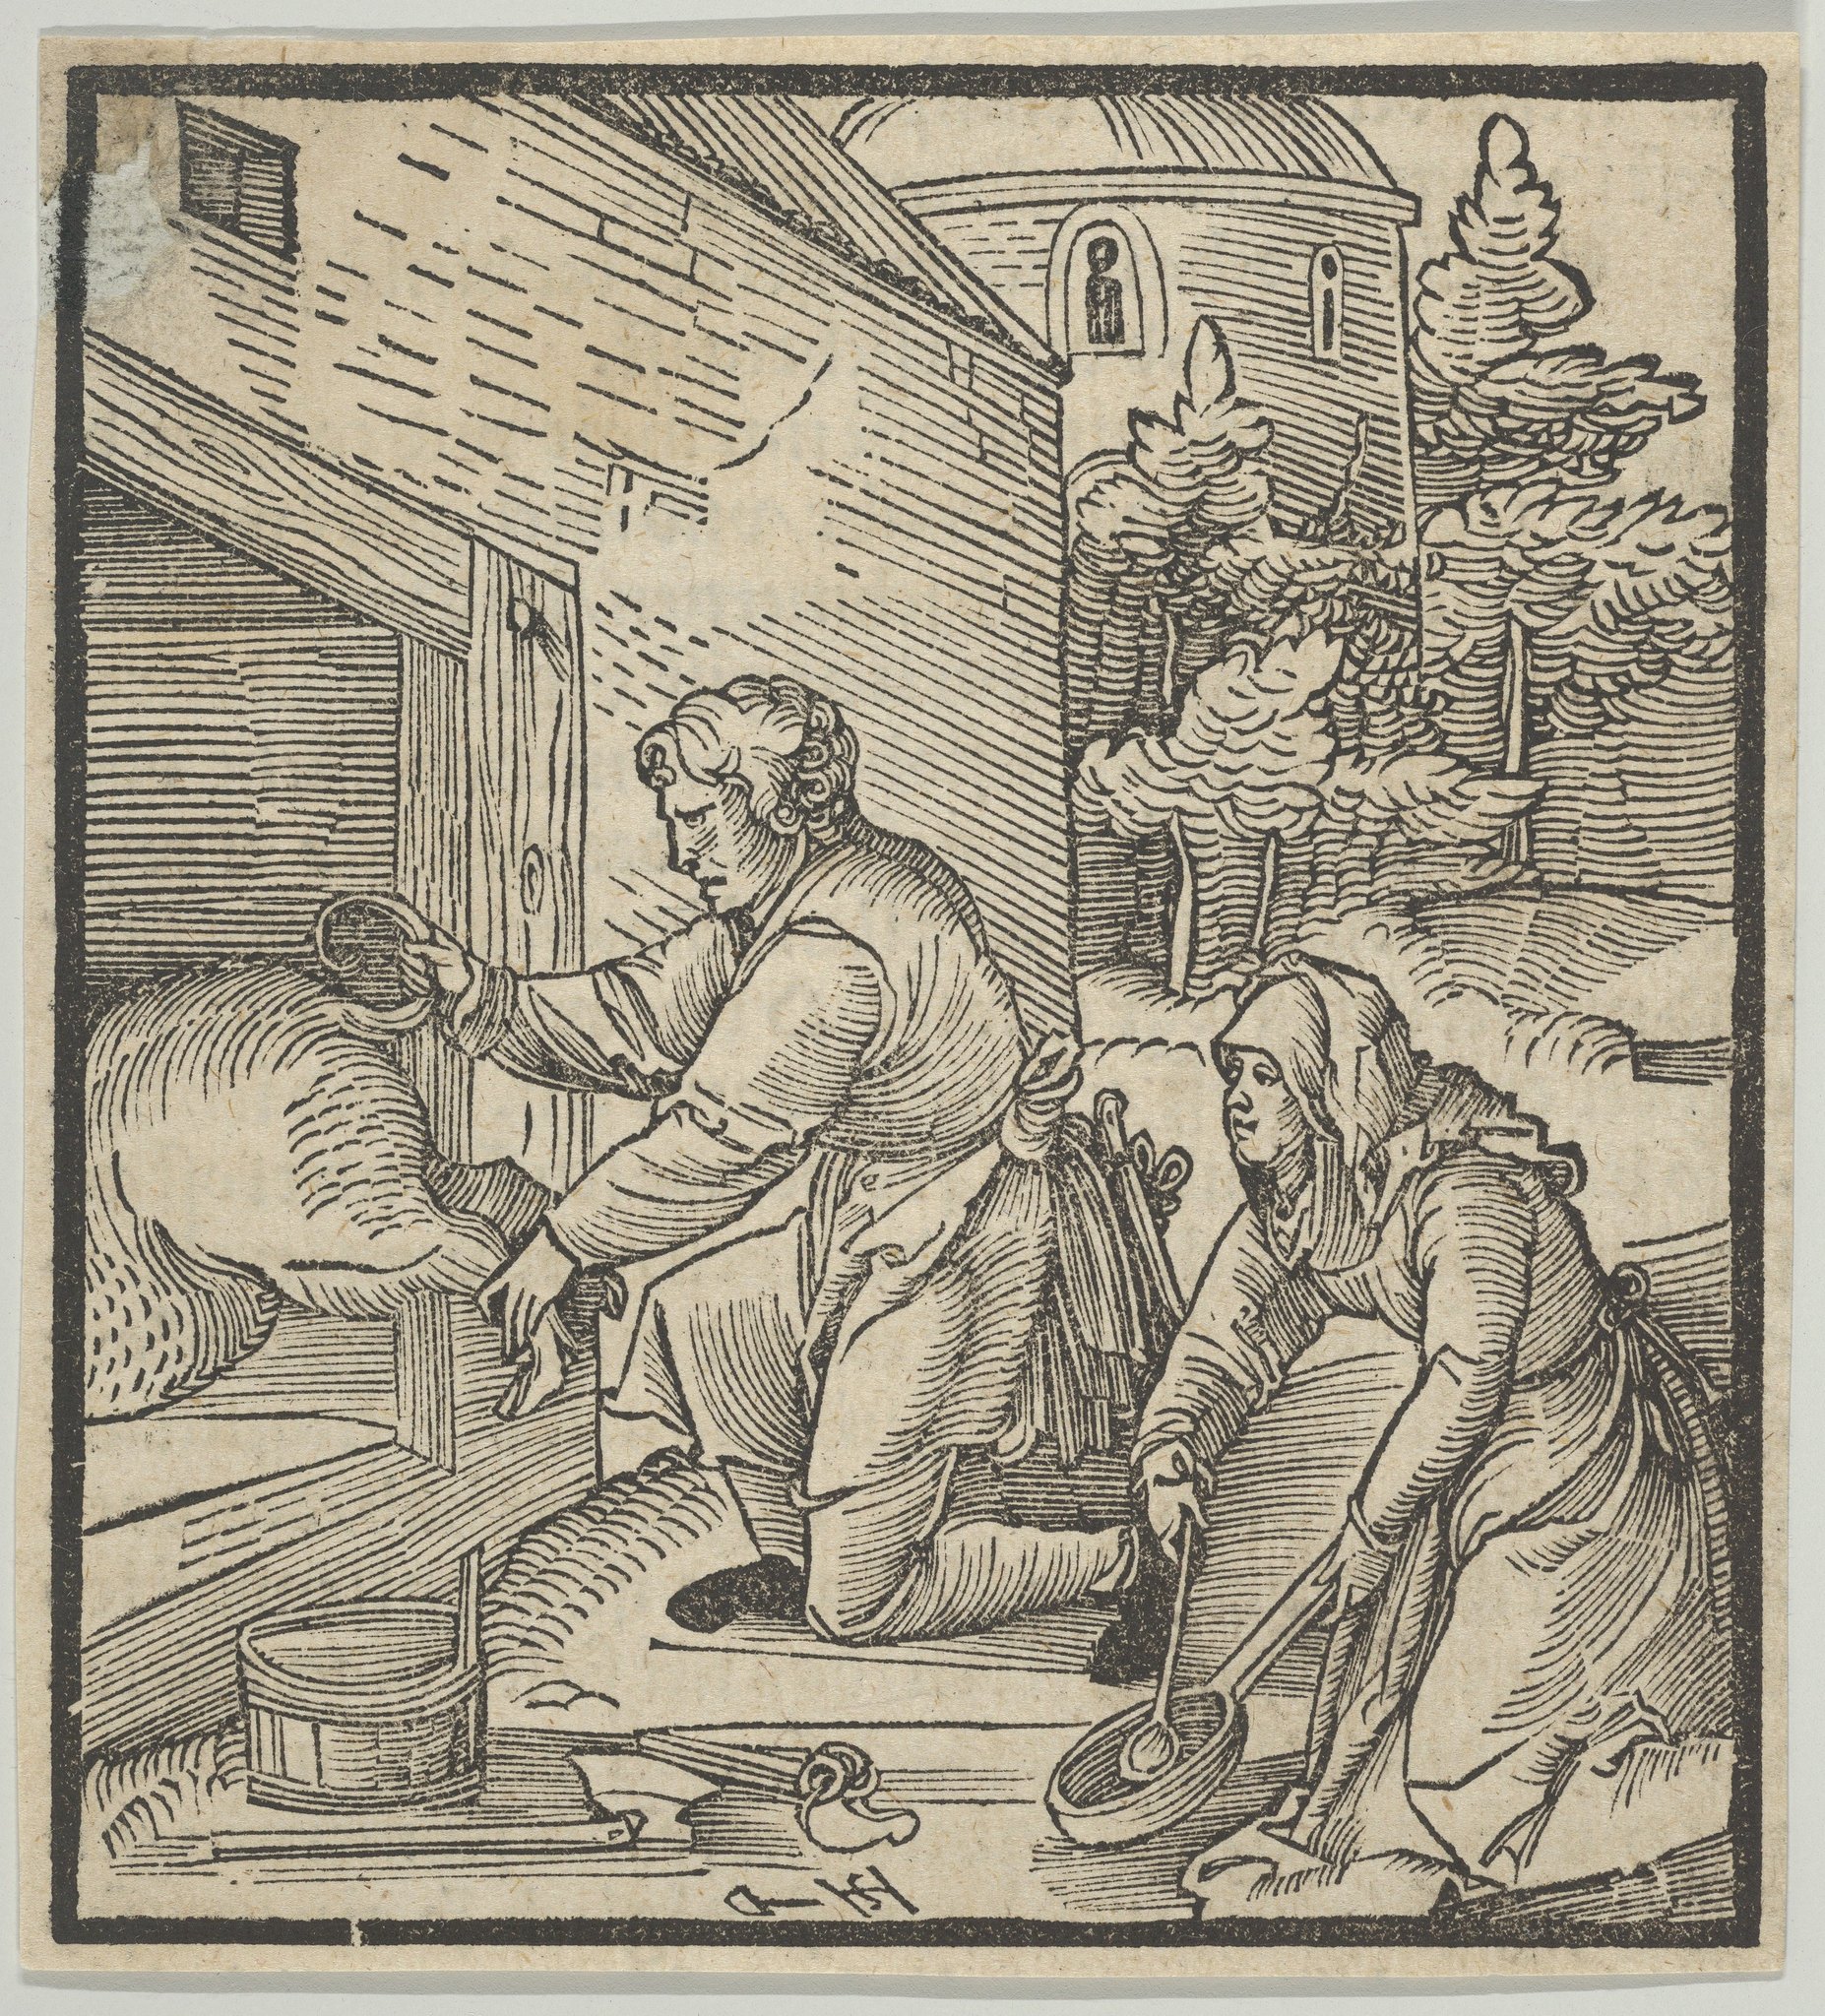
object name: print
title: A Farmer Slaughtering a Hog, from Hymmelwagen auff dem, wer wol lebt...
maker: hans schäufelein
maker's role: artist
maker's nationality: german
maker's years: 1480-1540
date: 1517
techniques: woodcut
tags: animals,men,women,farmers